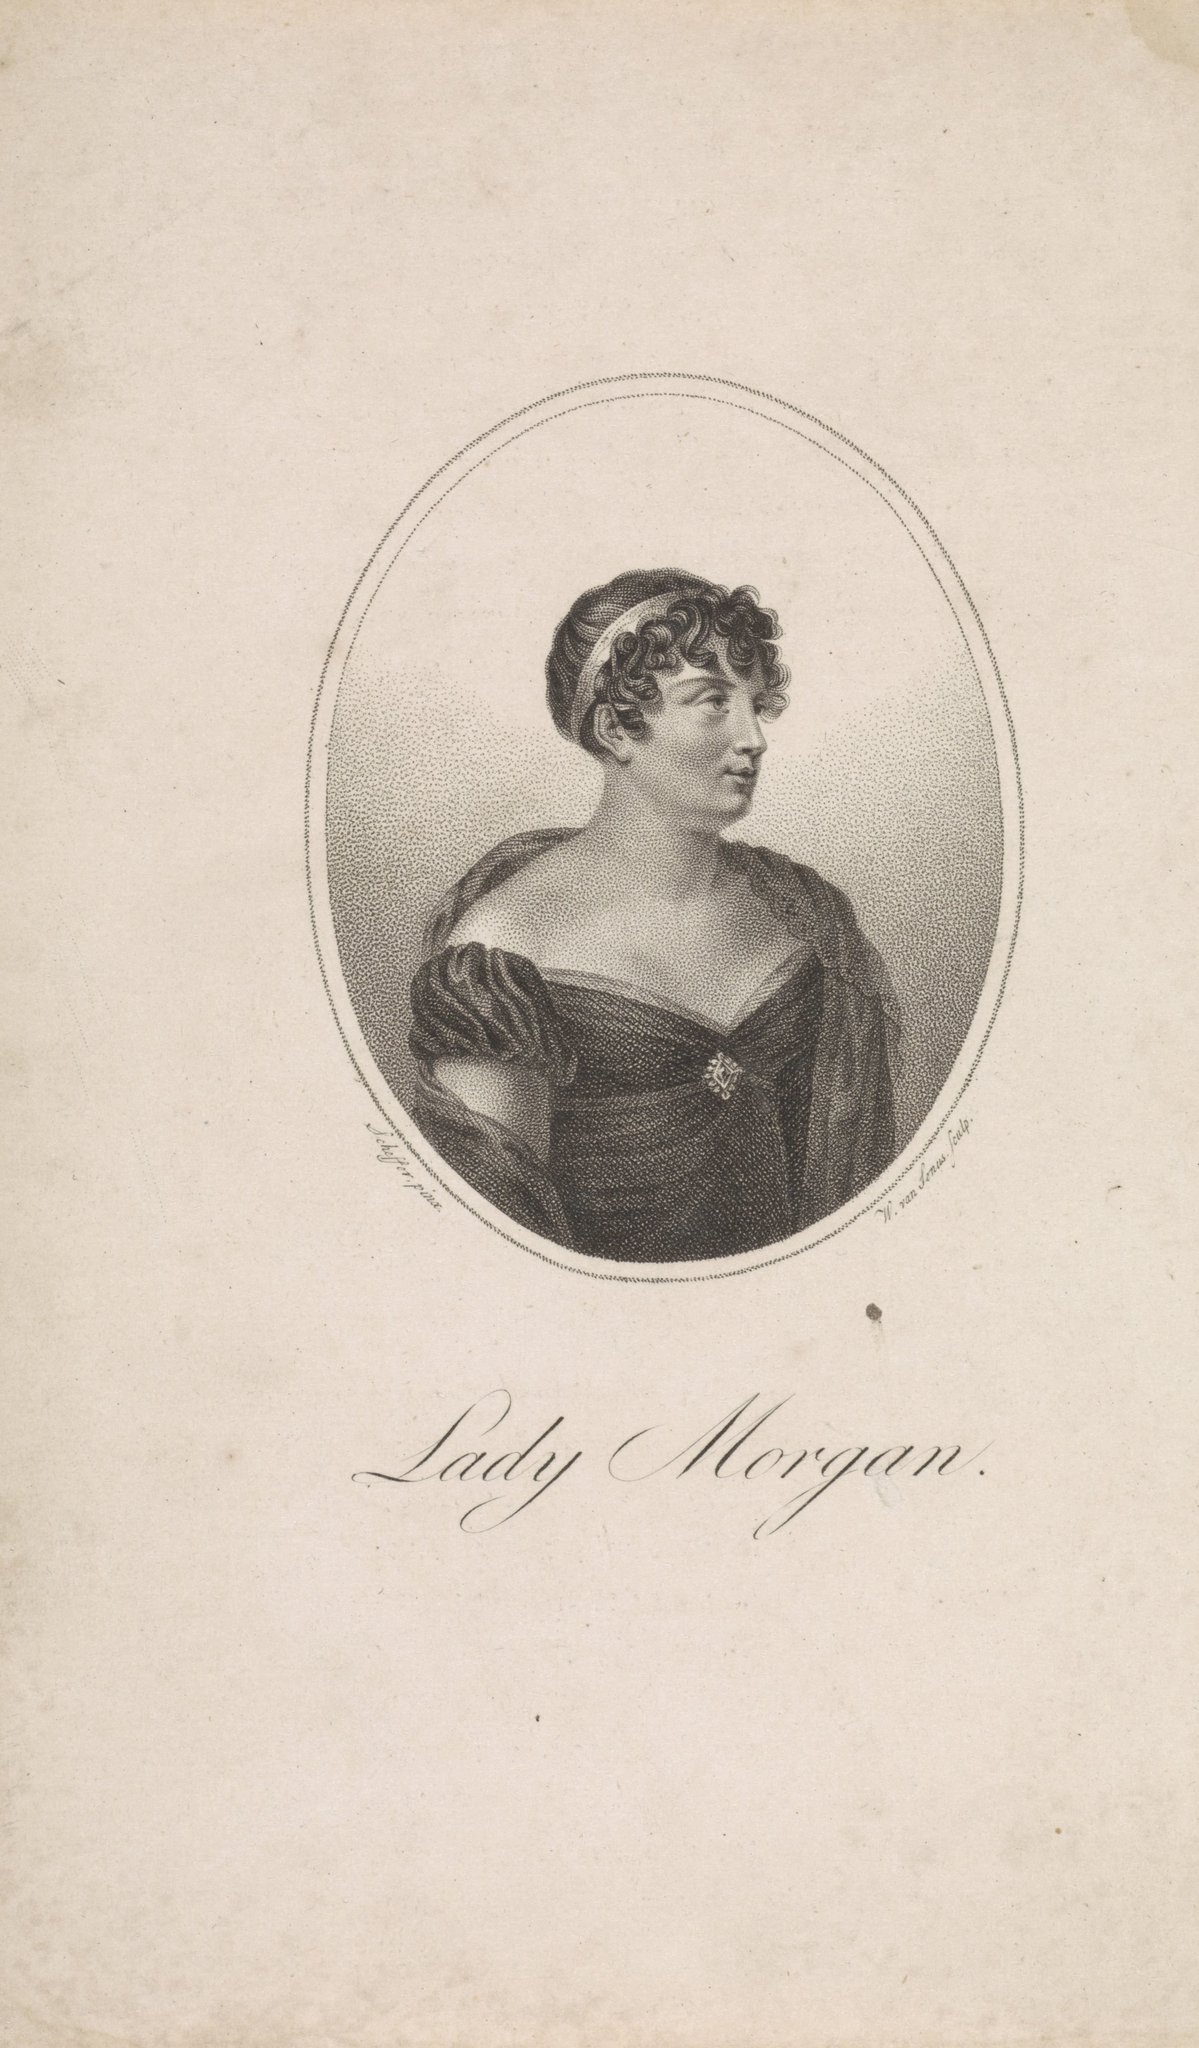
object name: print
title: Portret van Sydney, Lady Morgan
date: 1804-1851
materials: paper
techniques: etching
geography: netherlands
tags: ierland, schrijver, lady morgan sydney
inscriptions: collector's mark: Lugt 2228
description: Portret van de Ierse schrijfster Sydney, Lady Morgan.